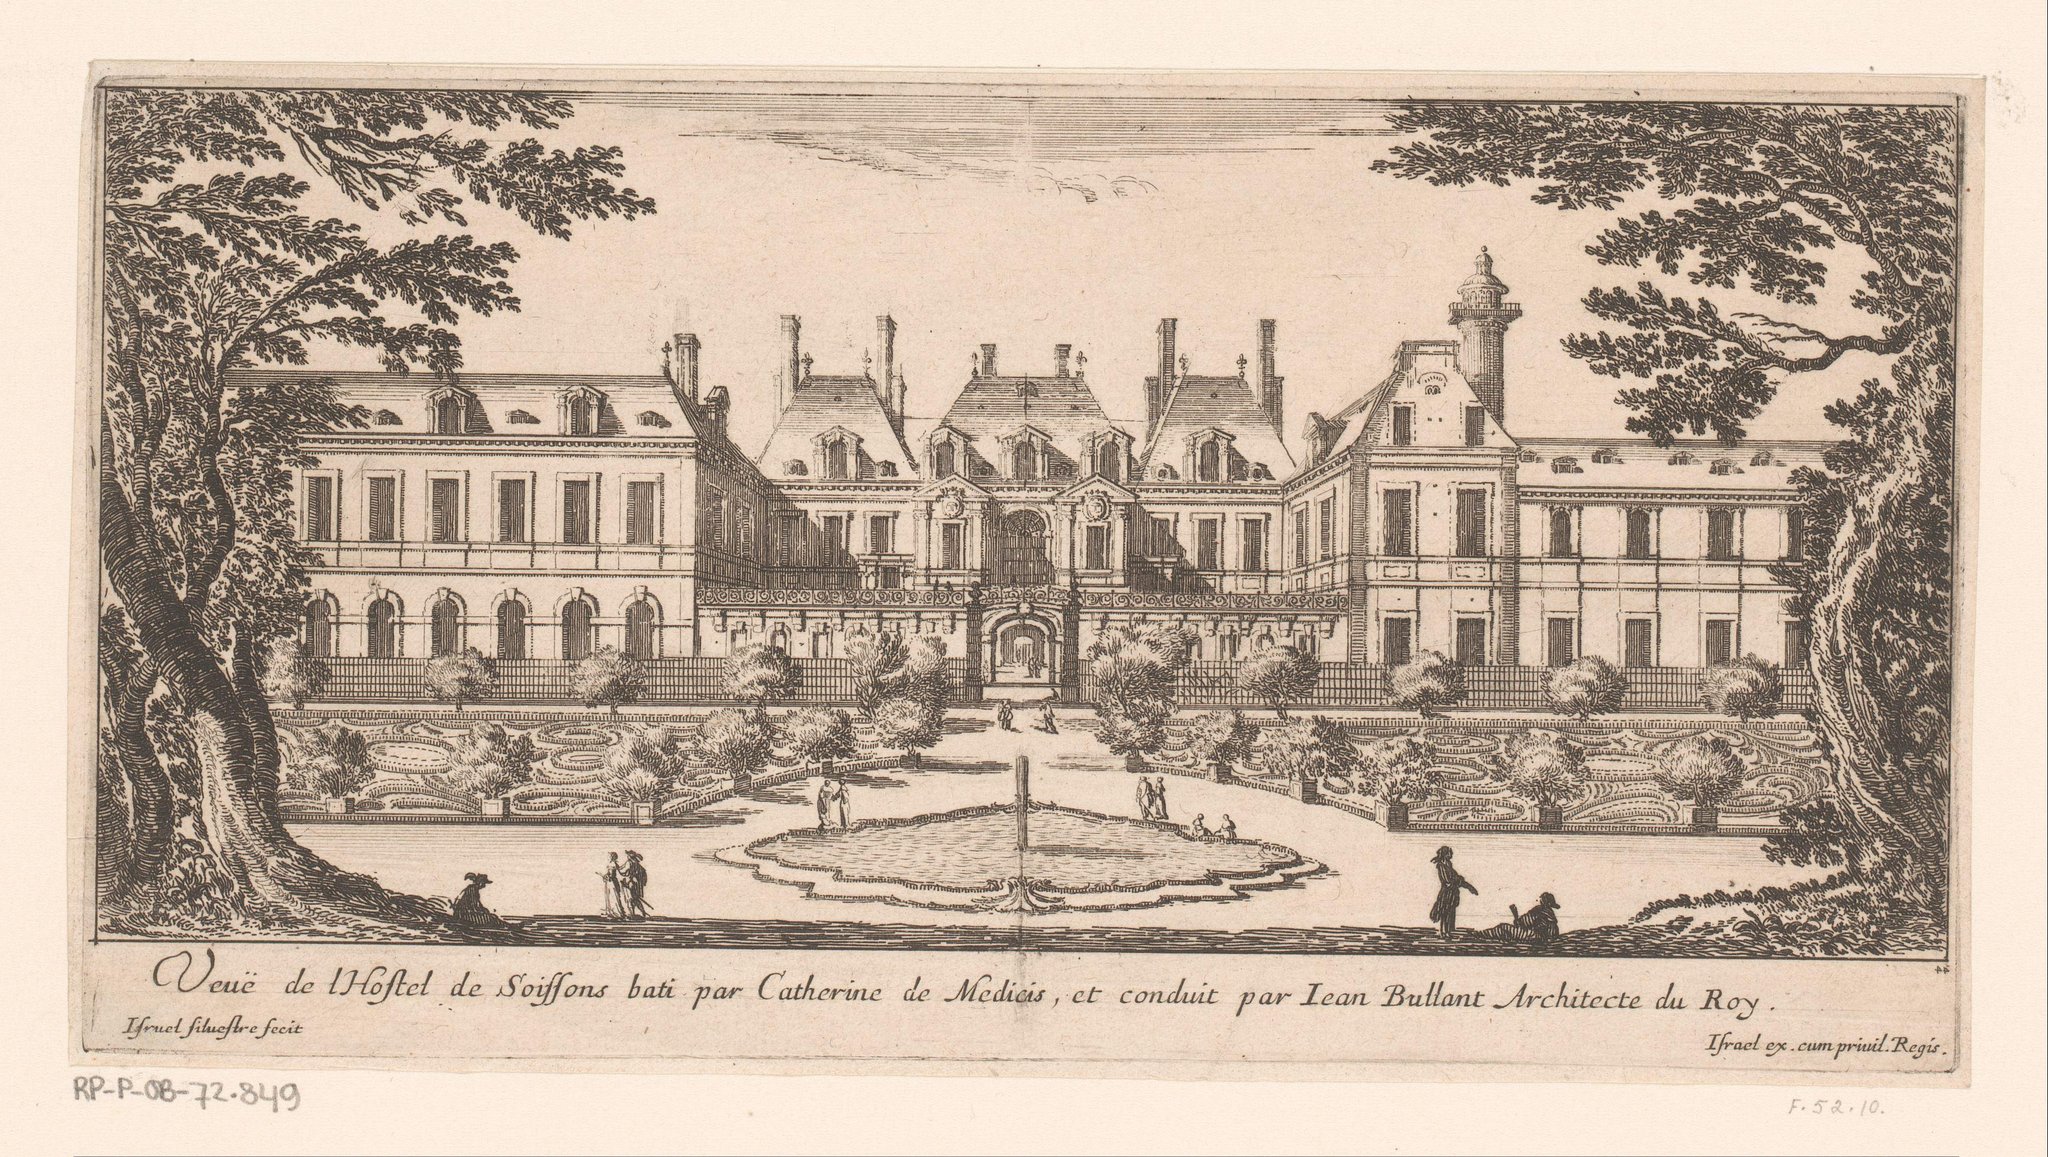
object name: print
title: Livre de diverses Perspectives et Paisages faits sur le naturel, mis en lumière par Israel 1650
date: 1650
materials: paper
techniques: etching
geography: france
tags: french or architectonic garden; formal garden, landscape with tower or castle, hôtel, i.e. small palace in city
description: Prent maakt deel uit van een ongenummerde serie van zestien prenten.